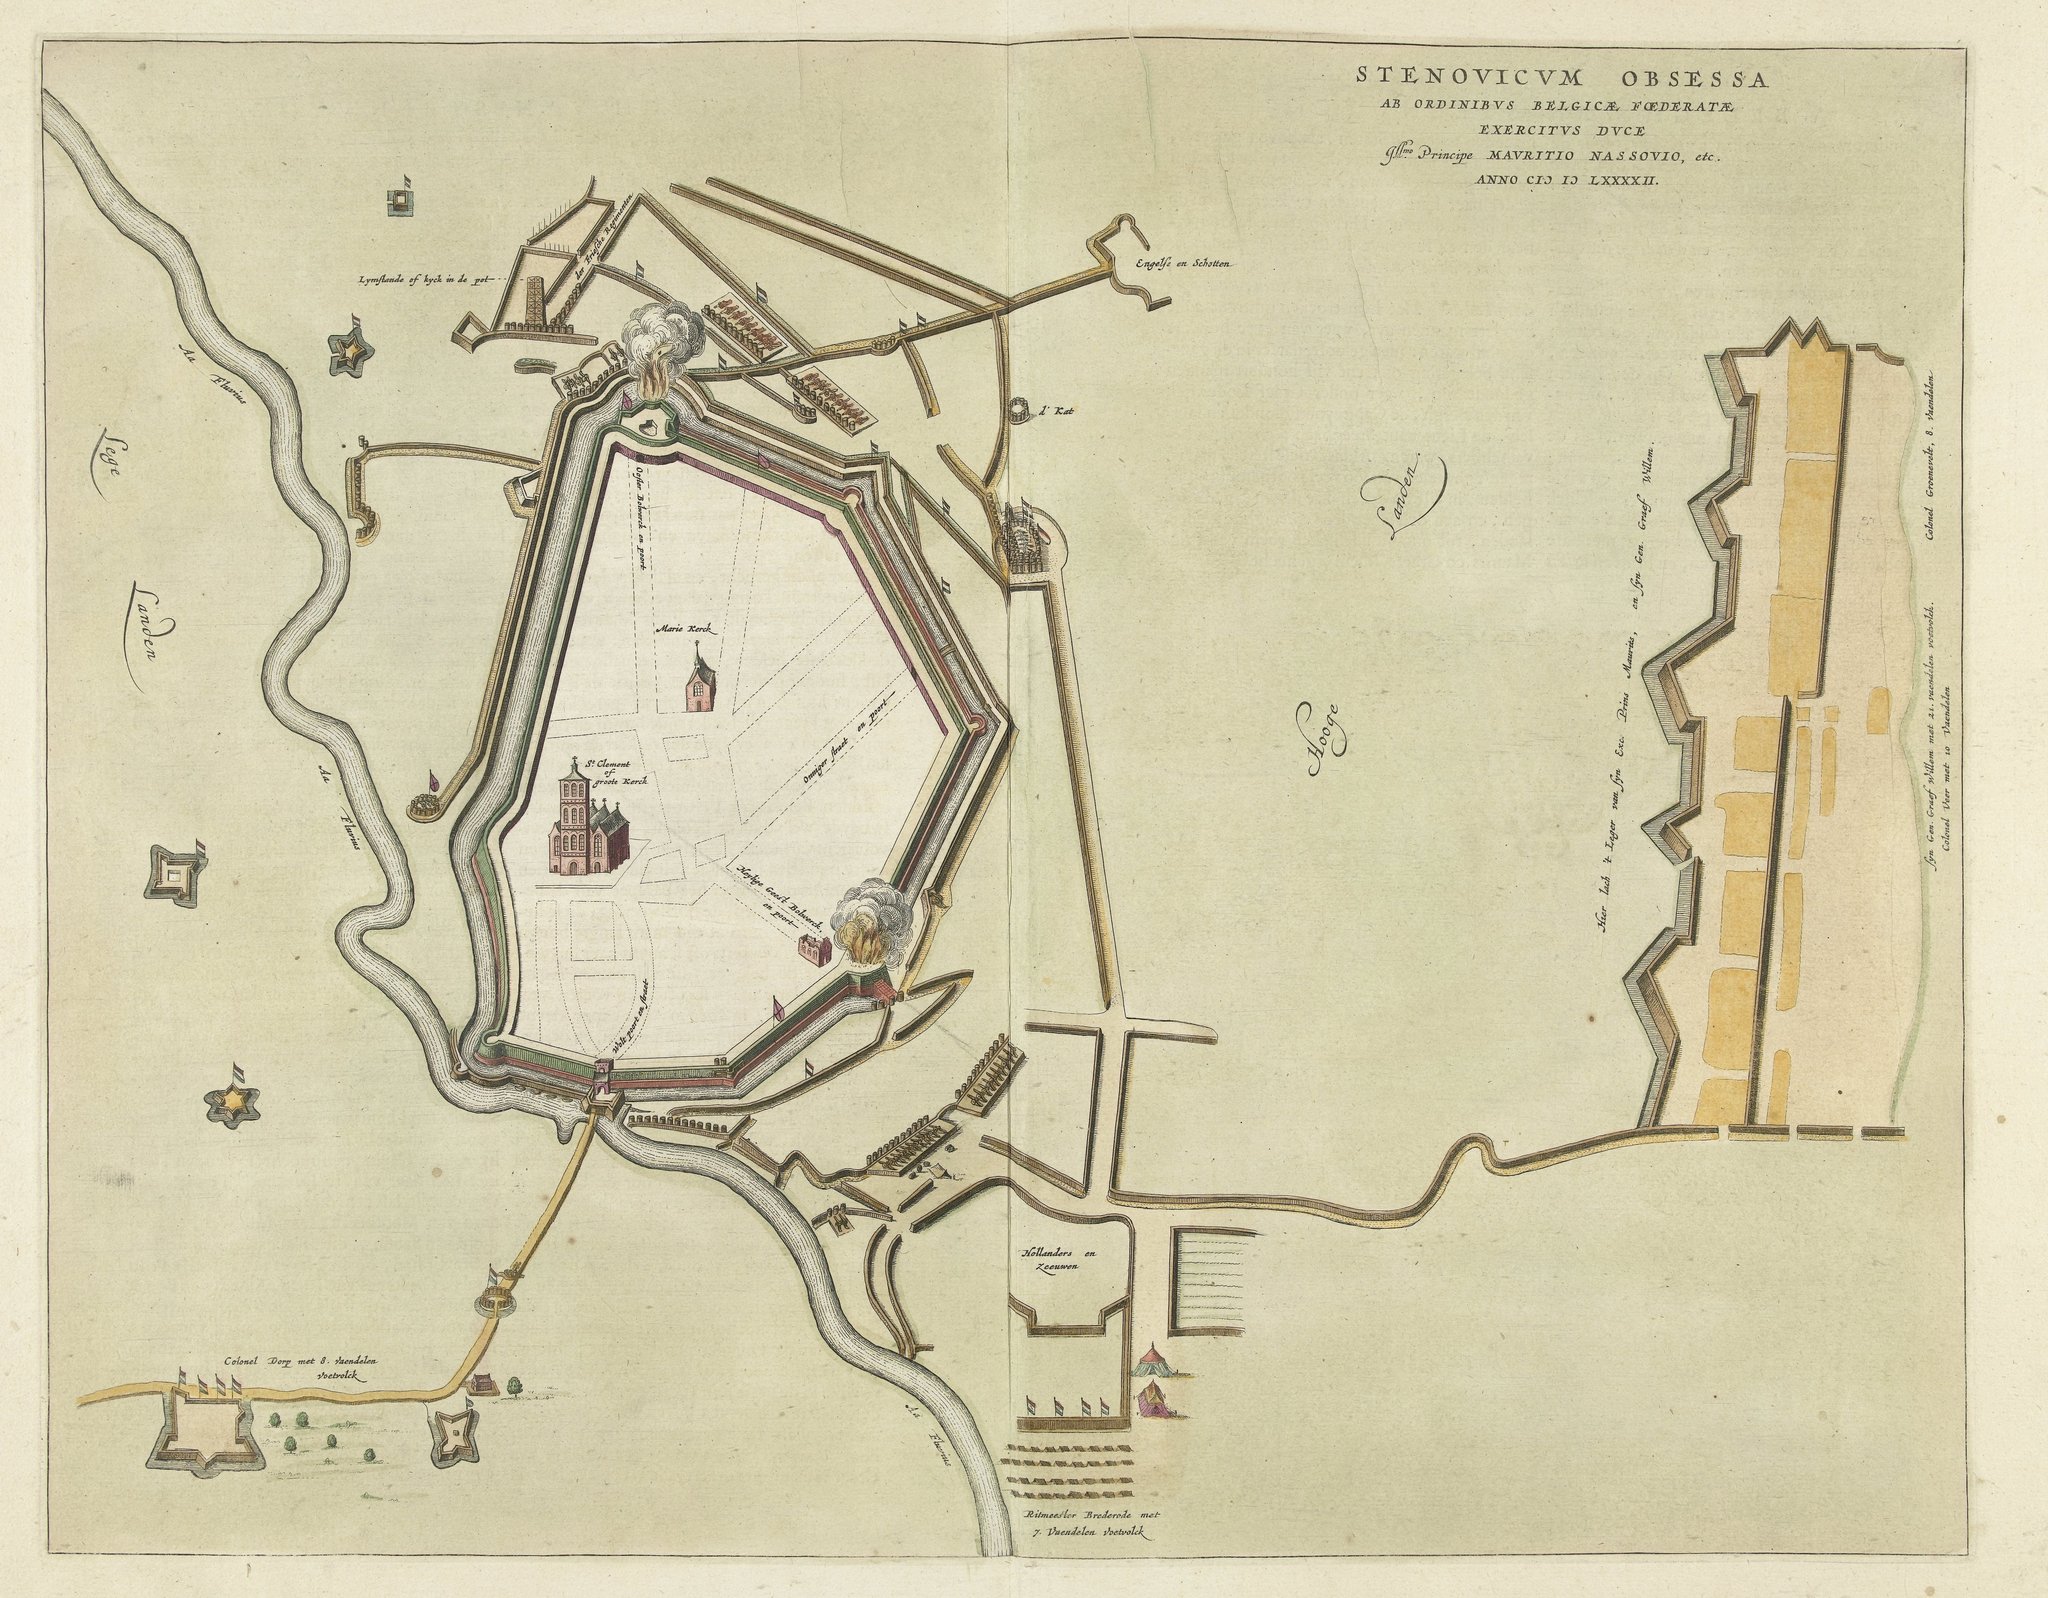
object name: history print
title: Kaart van het belegerde Steenwijk, 1592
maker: Anonymous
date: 1647-1649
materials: paper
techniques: etching, hand coloring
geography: northern netherlands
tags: maurice (prince of orange), siege, position war, maps of cities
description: Kaart van Steenwijk belegerd door het Staatse leger onder Maurits, mei - juli 1592. Plan van Steenwijk met de stadswallen en verdedigingswerken en de posities van de belegerende troepen. In de stad zijn alleen twee kerken en enkele straten aangegeven. Bij de stadmuren twee explosies. Op een dubbelblad uit het het Stedenboek van Blaeu genomen, op beide zijden bedrukt met tekst in het Nederlands.